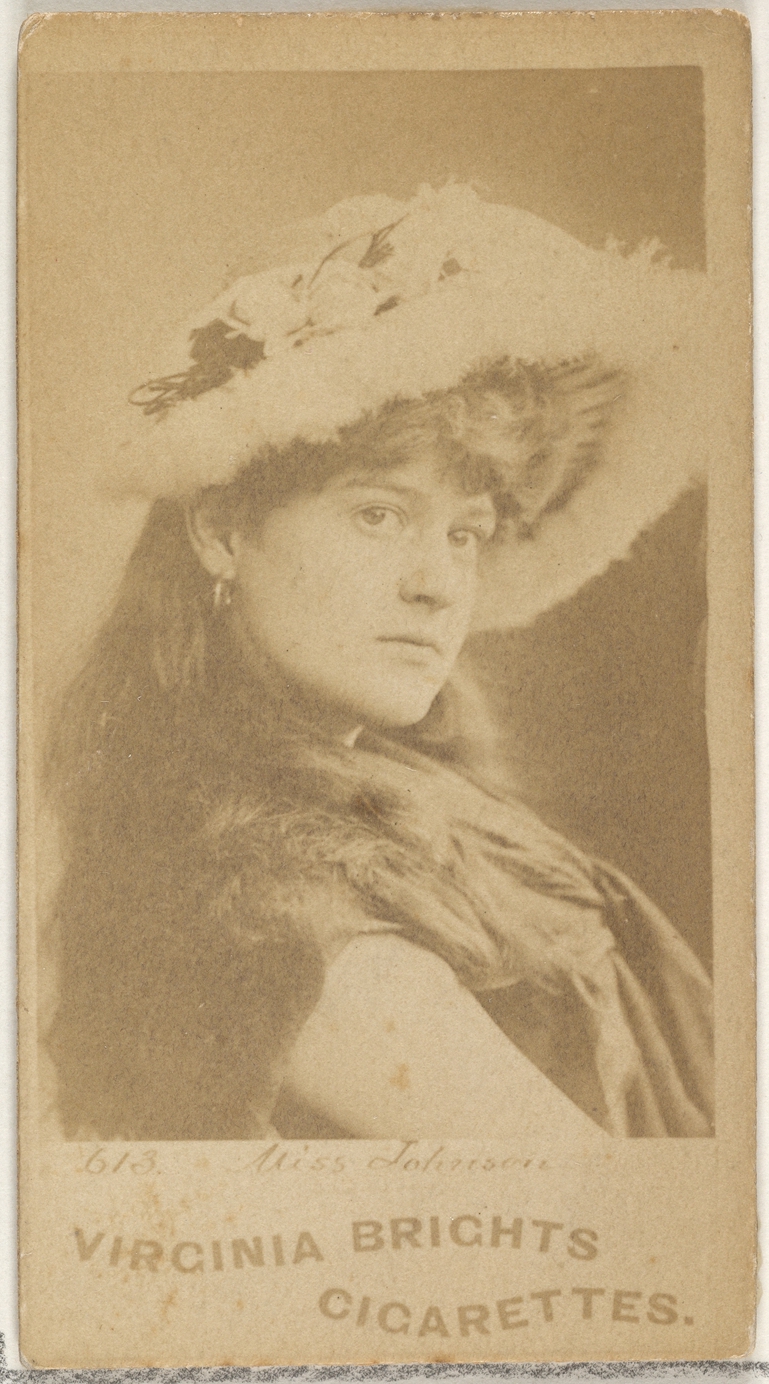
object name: photograph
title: Card 613, Miss Johnson, from the Actors and Actresses series (N45, Type 1) for Virginia Brights Cigarettes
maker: allen & ginter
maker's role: publisher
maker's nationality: american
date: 1888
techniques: albumen silver print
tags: portraits,women,actresses